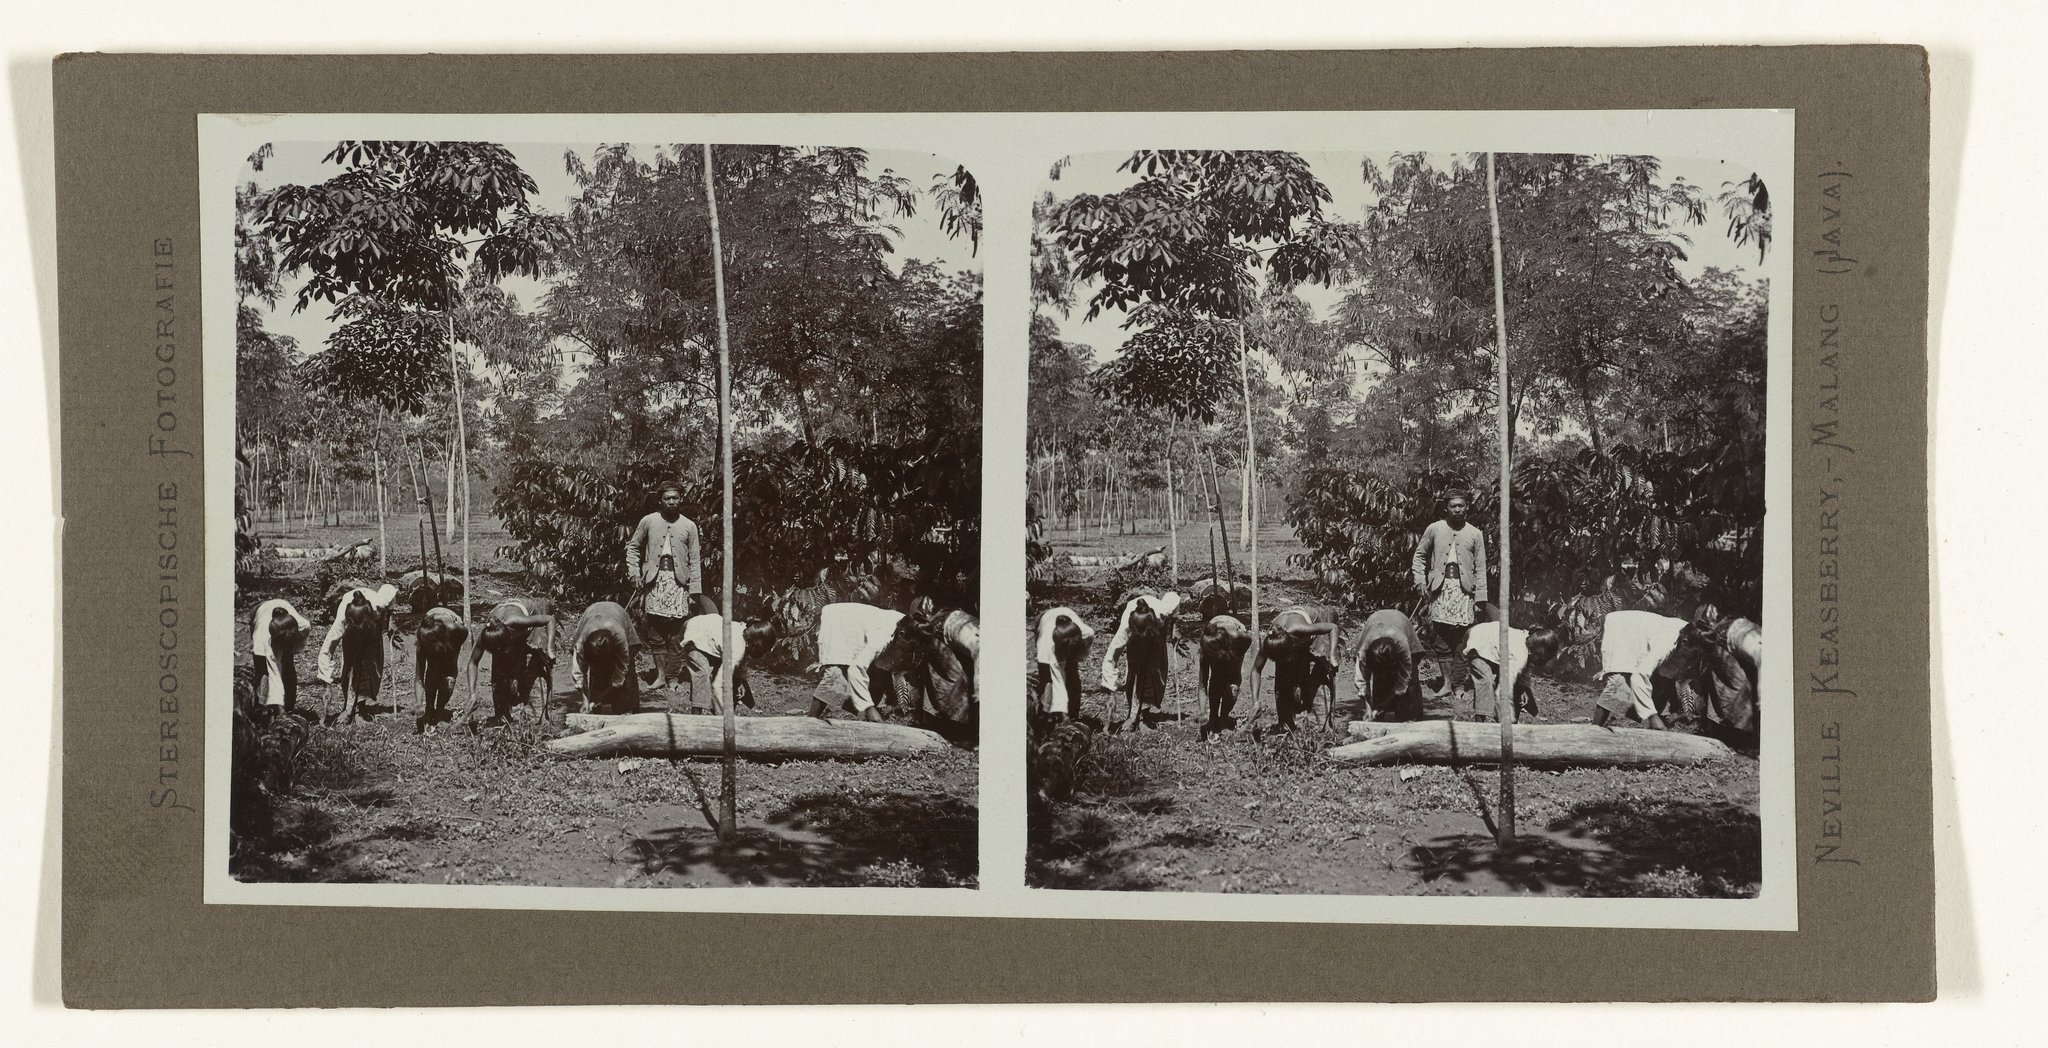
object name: stereograph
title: Javaanse vrouwen maken een rubbertuin schoon.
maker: neville keasberry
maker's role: fotograaf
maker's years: 1866-1944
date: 1900-1935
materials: cardboard, paper, photographic support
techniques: albumen print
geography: malang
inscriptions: signature: ‘Neville Keasberry, Malang (Java)’, inscription: ‘Stereoscopische Fotografie’